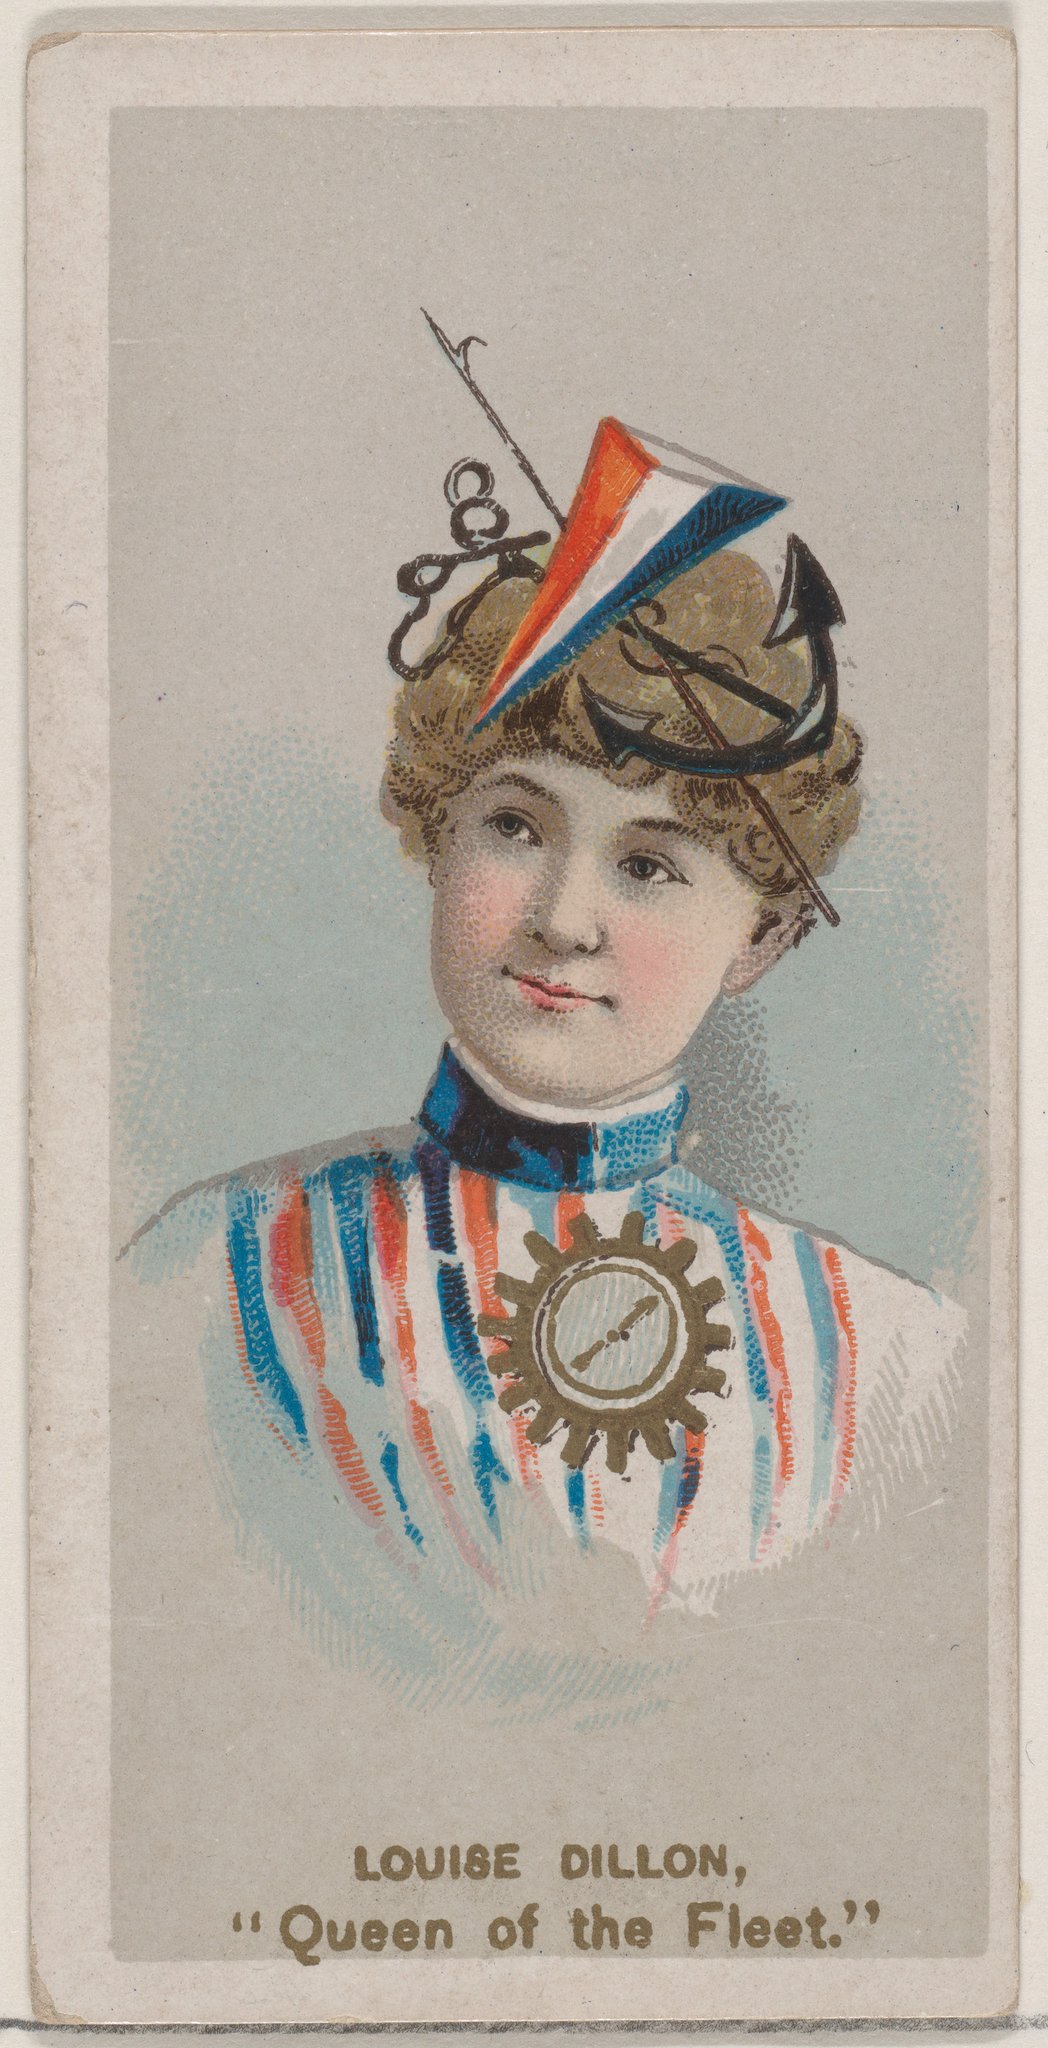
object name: print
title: Louise Dillon as "Queen of the Fleet," from the series Fancy Dress Ball Costumes (N73) for Duke brand cigarettes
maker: w. duke, sons & co.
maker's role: publisher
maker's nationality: american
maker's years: 1870-1920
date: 1889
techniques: color lithograph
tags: women,actresses